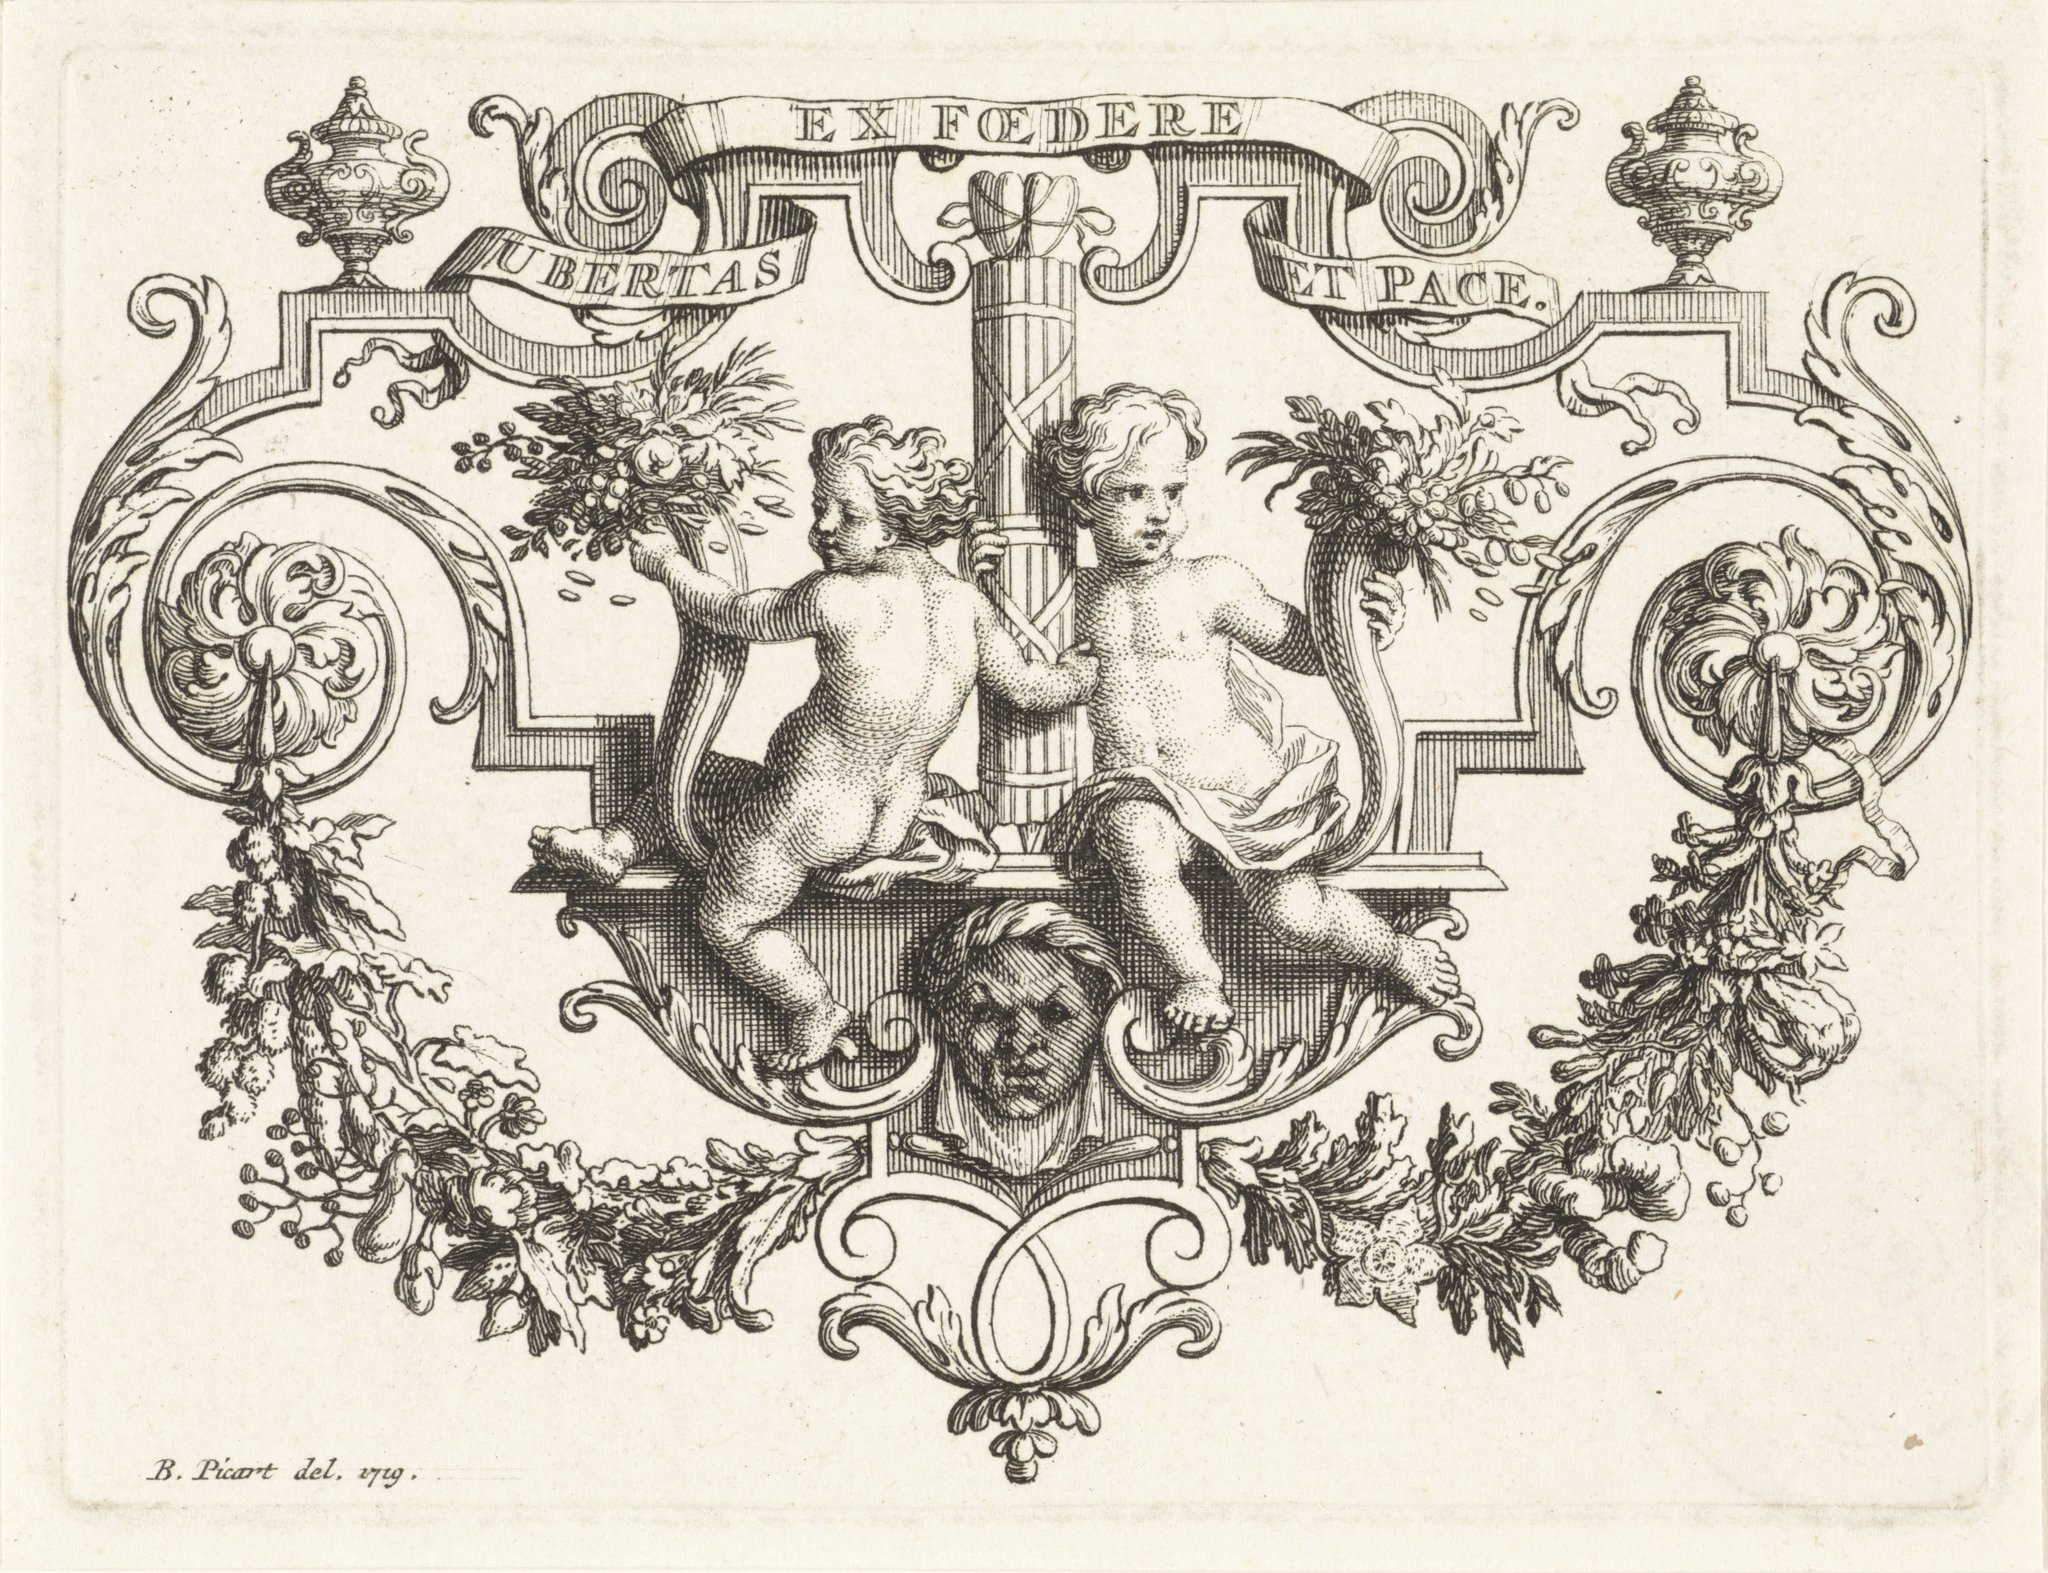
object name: ornament print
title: Ornamenten en in het centrum putti met een hoorn des overvloeds in de hand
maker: bernard picart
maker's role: draughtsman, print maker, publisher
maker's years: 1673-1733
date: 1719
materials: paper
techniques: engraving, etching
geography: amsterdam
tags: 'cornucopia', horn of plenty, ornaments ~ art, cupids: 'amores', 'amoretti', 'putti'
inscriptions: collector's mark: Lugt 240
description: Ornamenten en in het centrum twee putti met een hoorn des overvloeds in de handen. Bovenaan een devies: Ubertas Ex Foedere et Pace.